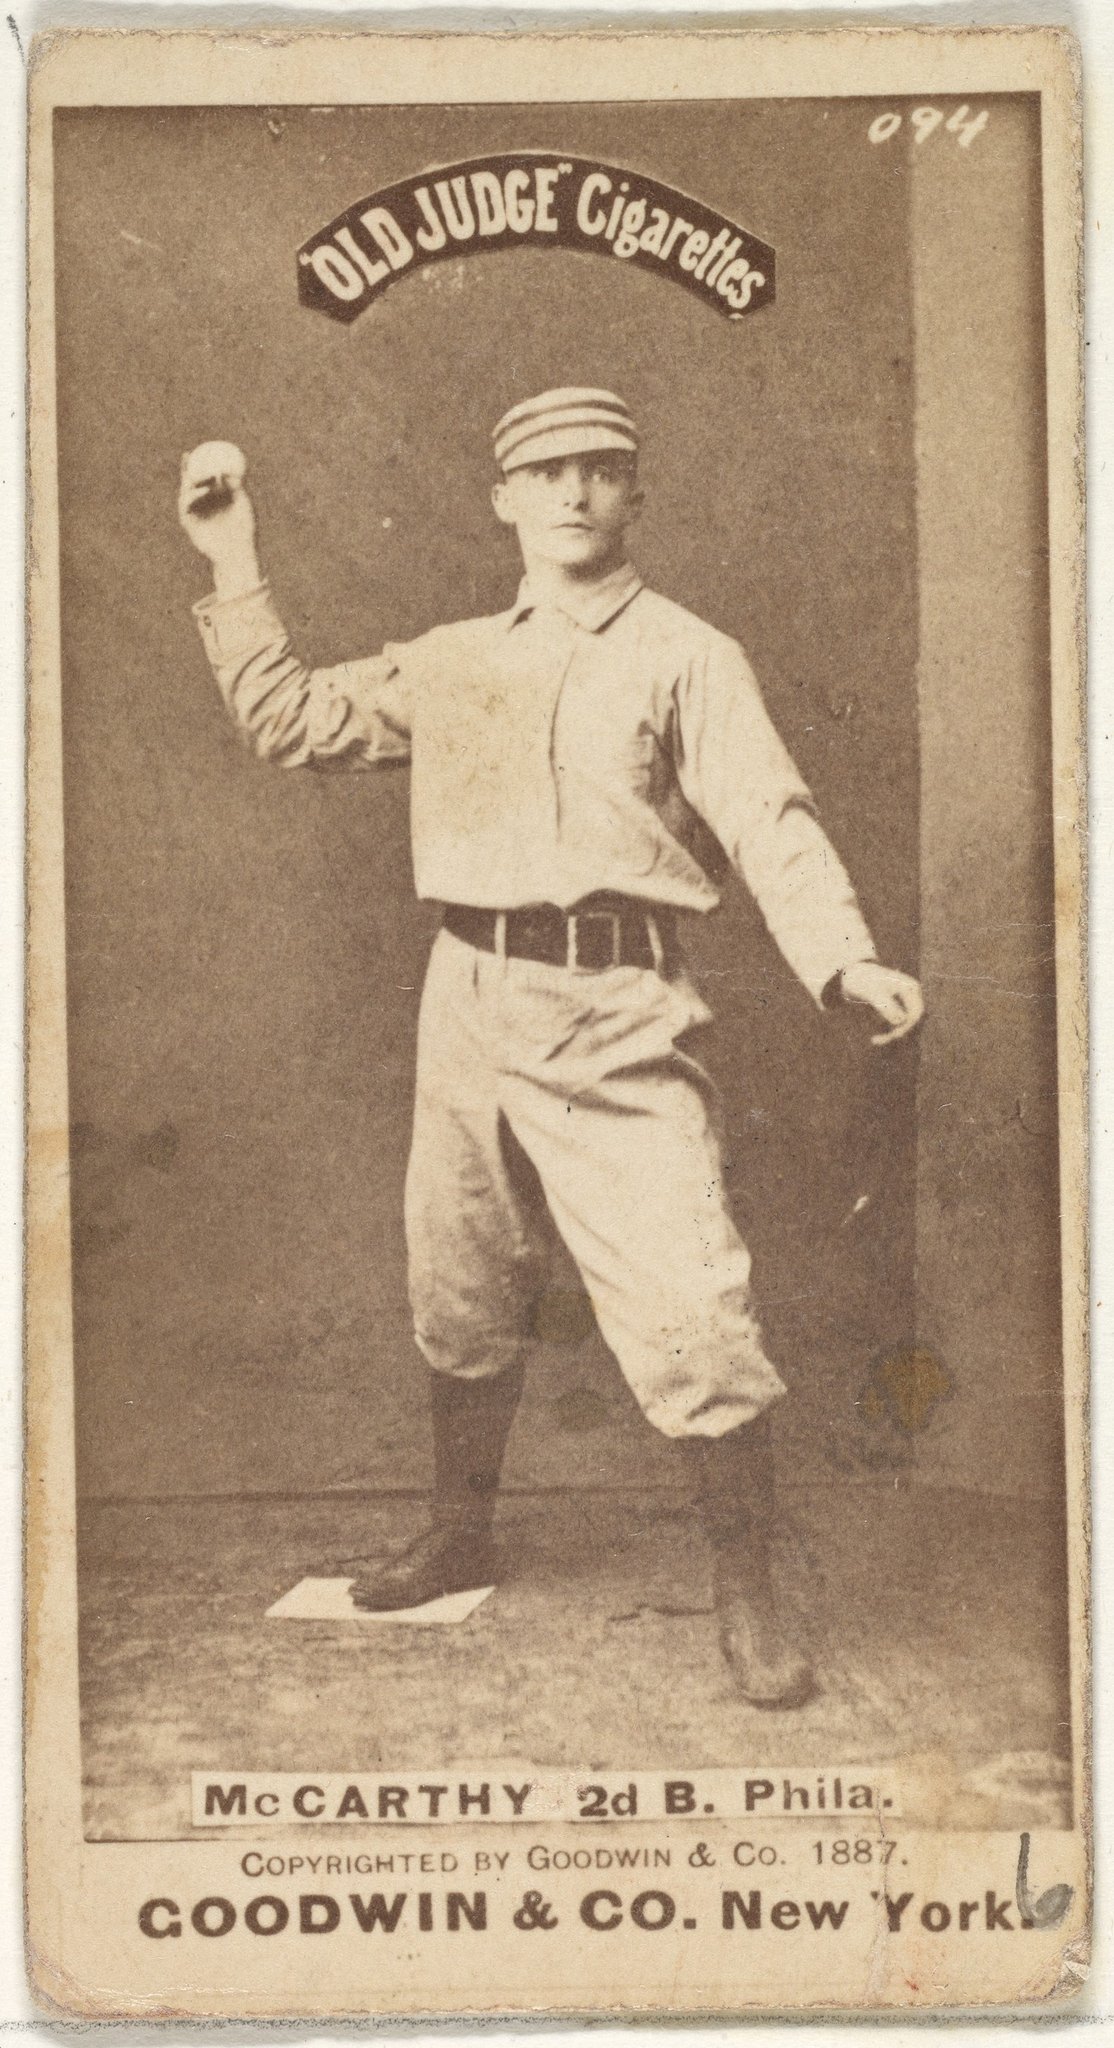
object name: baseball card, photograph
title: Thomas Francis Michael "Tommy" McCarthy, 2nd Base, Philadelphia, from the Old Judge series (N172) for Old Judge Cigarettes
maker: goodwin & company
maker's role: publisher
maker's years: 1850-1950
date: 1887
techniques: albumen silver print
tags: men,portraits,baseball,athletes